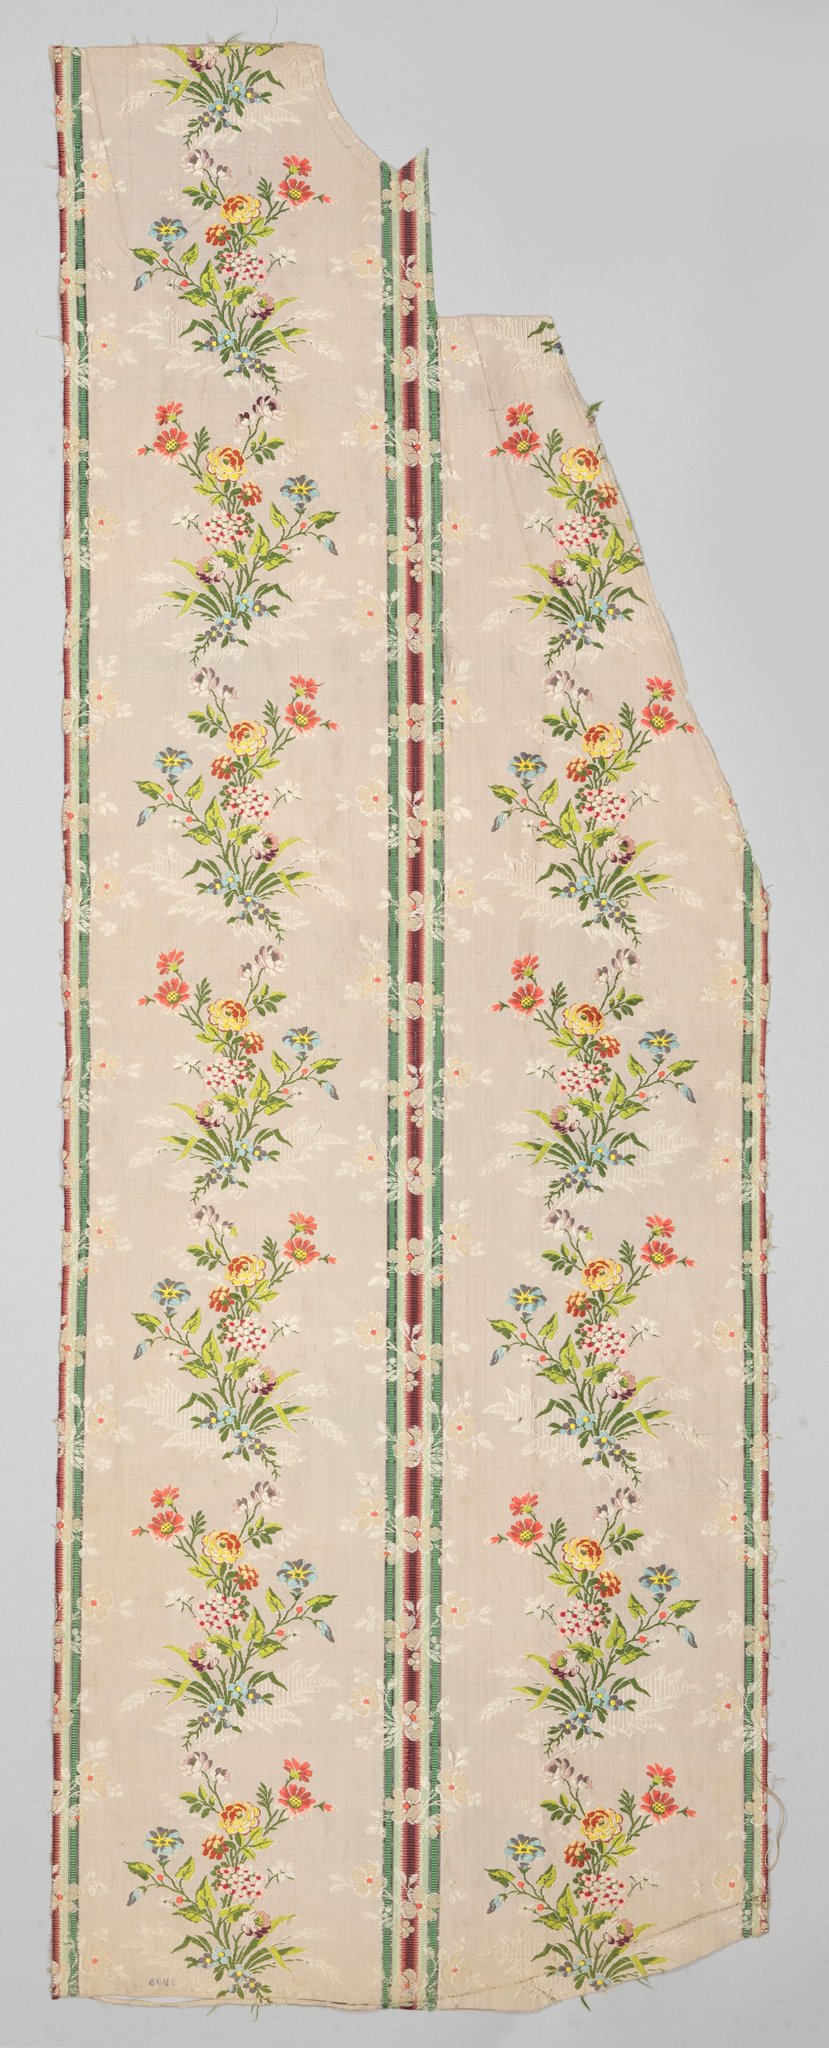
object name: fragment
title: Baan gebrocheerde Gros de Tours met strepen en bloemen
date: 1780-1785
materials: silk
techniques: brocade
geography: france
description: Baan gebrocheerde Gros de Tours. Dessin: verticale strepen in twee tinten groen en twee tinten rood, met écrukleurige bloemen (cannelé simpleté) met roze/ornaje hart waartussen om en om herhalende boeketten in diverse kleuren (brochering) op een écru fond (liseré-effect). Oorspronkelijk baan van japon. Aan achterzijde gestempeld nummer 6995. opgespeld papiertje met de letter A.